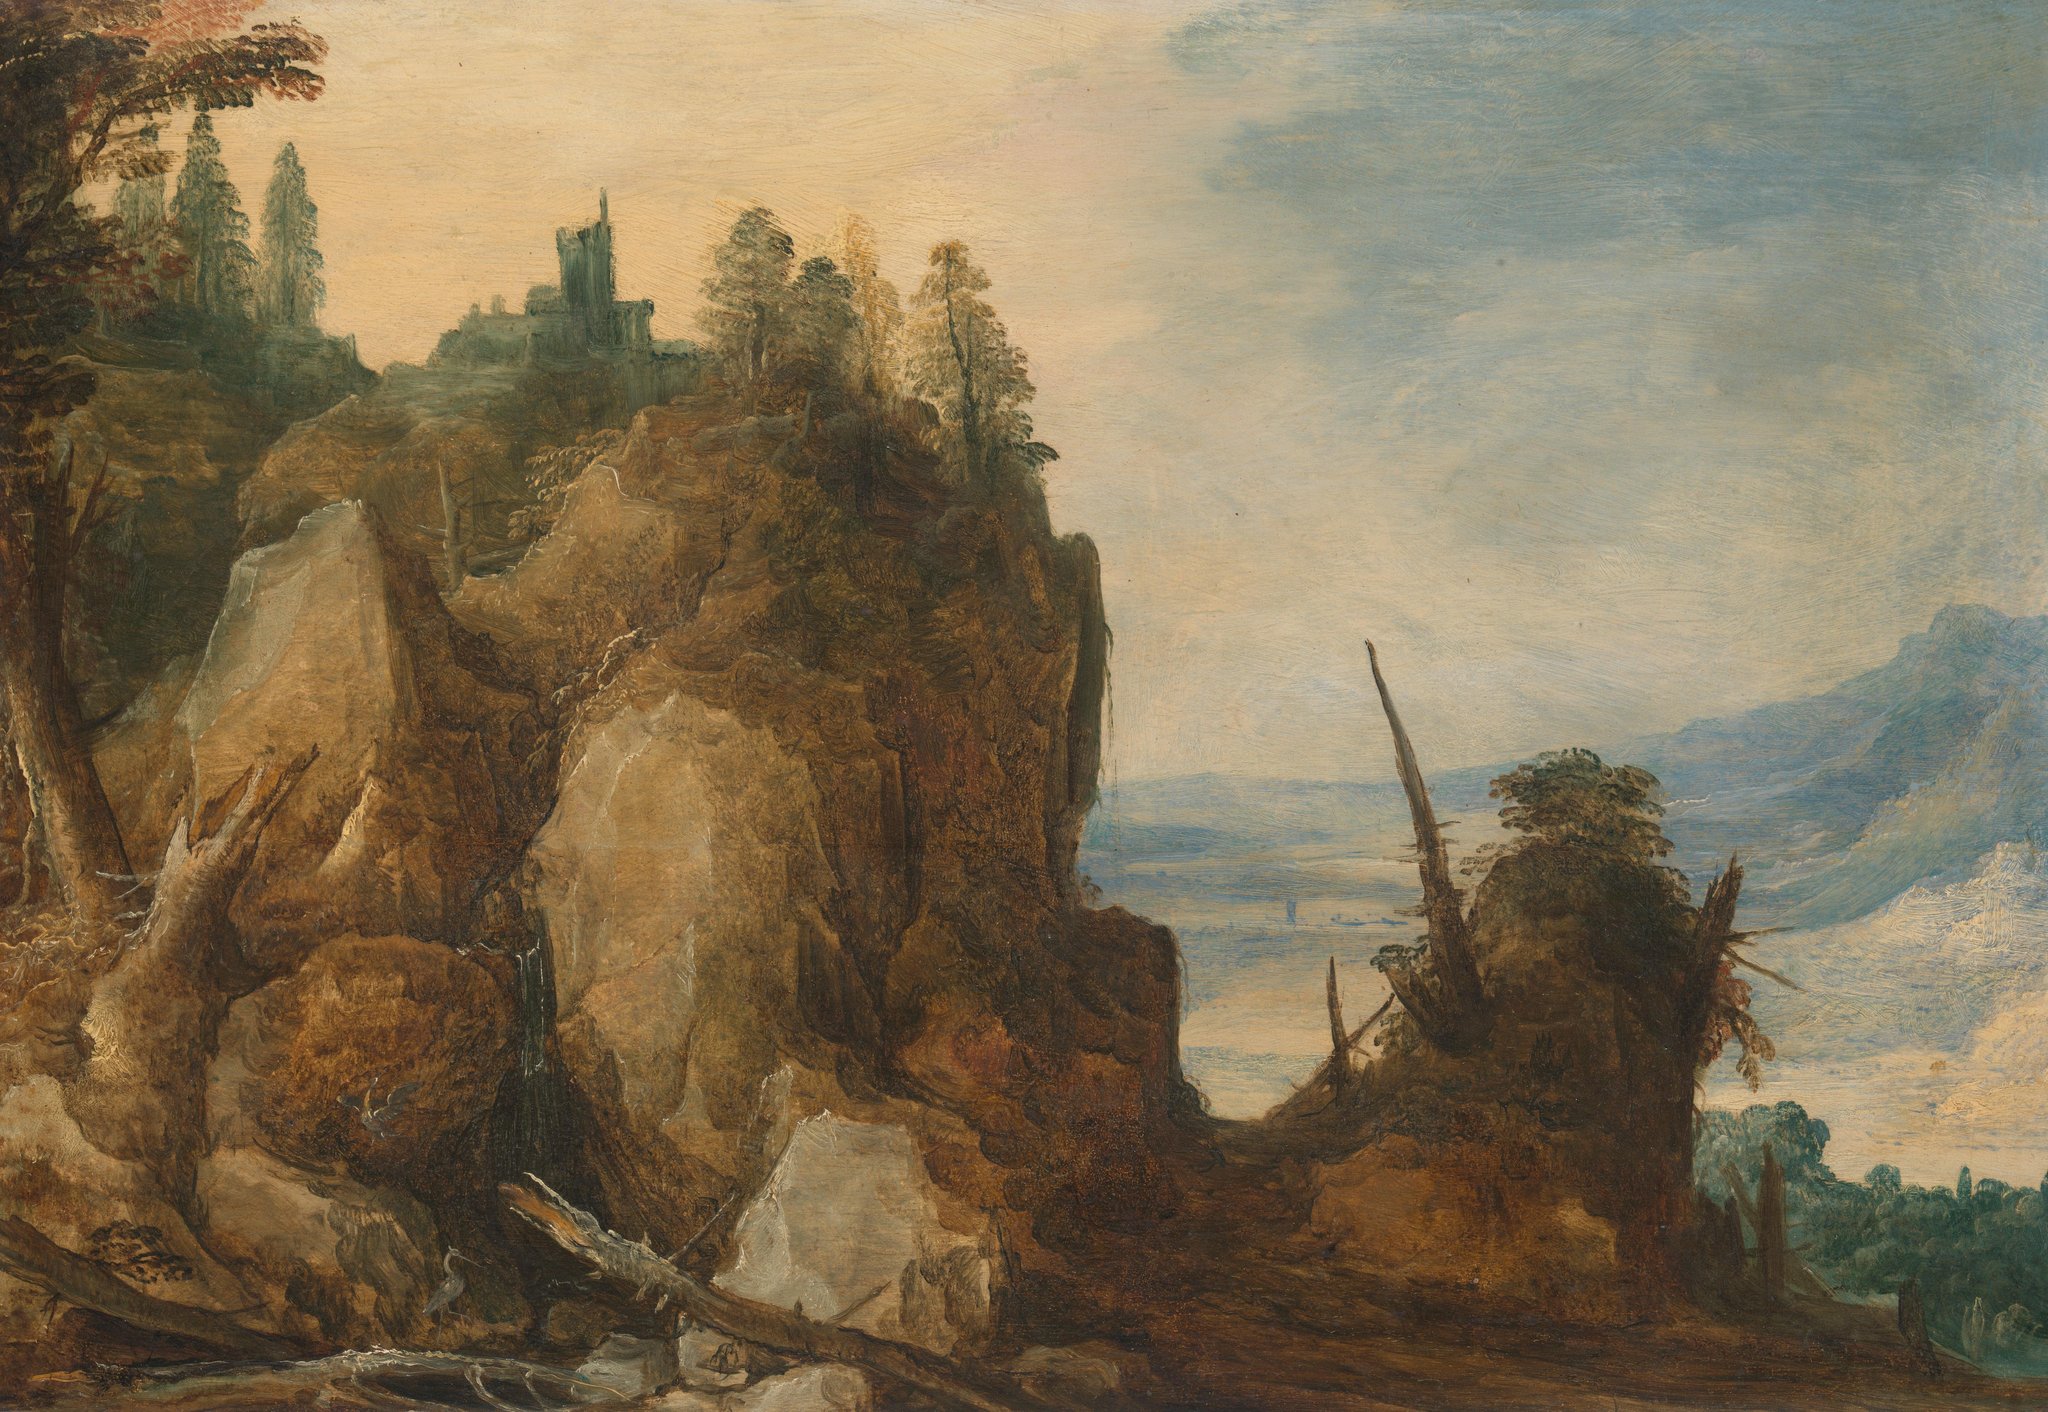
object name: painting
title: Mountain view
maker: joos de momper (ii)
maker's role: draughtsman, painter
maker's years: 1564-1635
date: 1590-1635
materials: oil, panel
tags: mountains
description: Rotsachtig berglandschap met links een kasteel gelegen op een hoge rots.